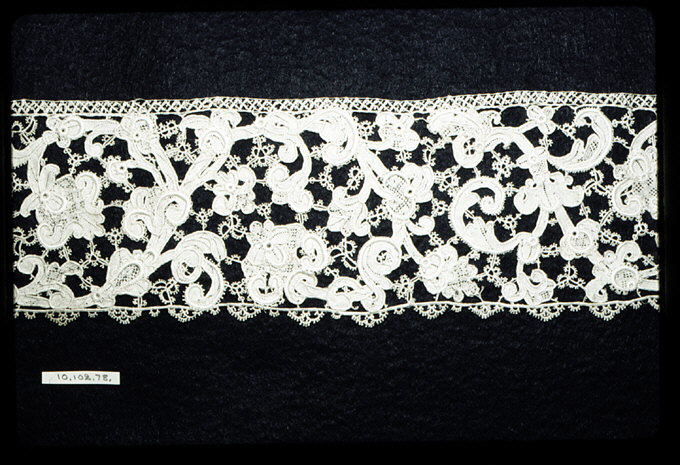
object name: fragment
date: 1601-1700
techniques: lace